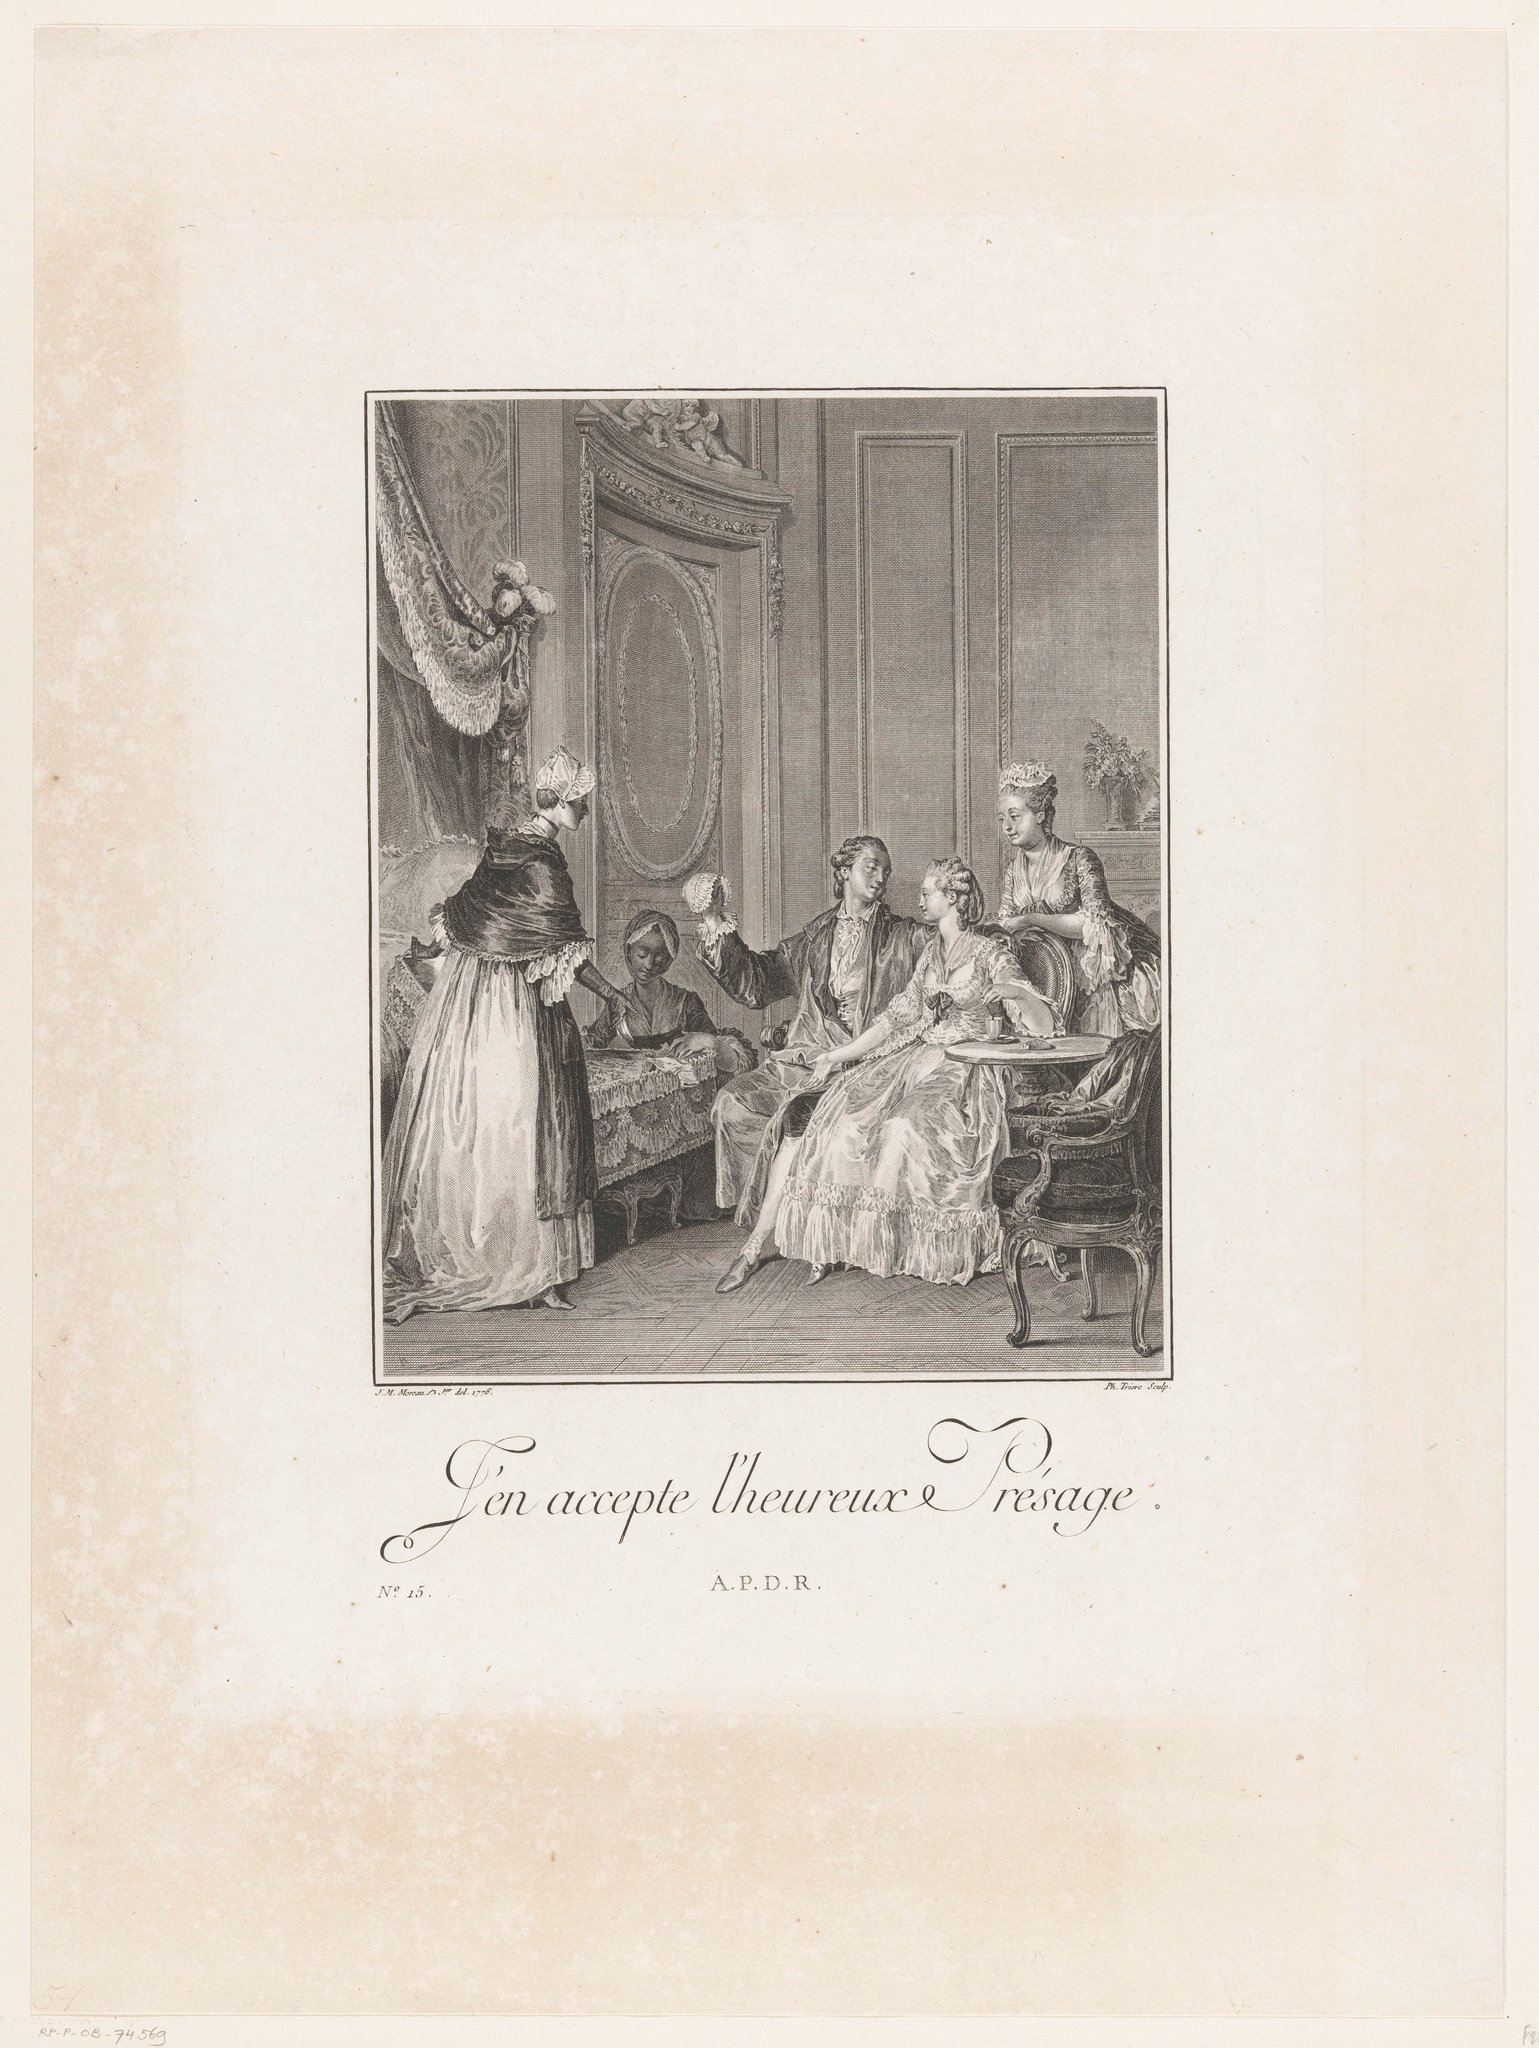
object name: print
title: Le Monument du Costume. Suite d'estampes pour servir à l'histoire des moeurs et du costume français dans le dix-huitième siècle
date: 1777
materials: paper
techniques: etching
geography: france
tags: clothing for the upper part of the body (caraco) (+ women's clothes), head-gear: cap (+ girls' clothes), parents with their children, housecoat (+ men's clothes), clothing for the upper part of the body (mantelet) (+ women's clothes), head-gear: cap (+ women's clothes), clothes, costume (+ women's clothes), skirt (+ women's clothes), gloves, mittens, etc. (+ women's clothes), clothes, costume (+ men's clothes), cradle, crib, maid ~ house personnel, piece of clothing covering the breast or décolleté (fichu) (+ women's clothes), cup and saucer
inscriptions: title: ‘J'en accepte l'heureux Présage’, number: ‘No. 15’, signature and date: ‘J.M. Moreau del. 1776’, signature: ‘Ph. Trière Sculp.’, privilege: ‘A.P.D.R.’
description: Céphise en haar echtgenoot zitten aan een tafeltje in een slaapvertrek met links een hemelbed. De man is gekleed in een japonse rok of kamerjas. Hij houdt Céphise een wit babymutsje voor (dat mogelijk wordt verkocht door de vrouw linksvoor met de mand aan de arm).